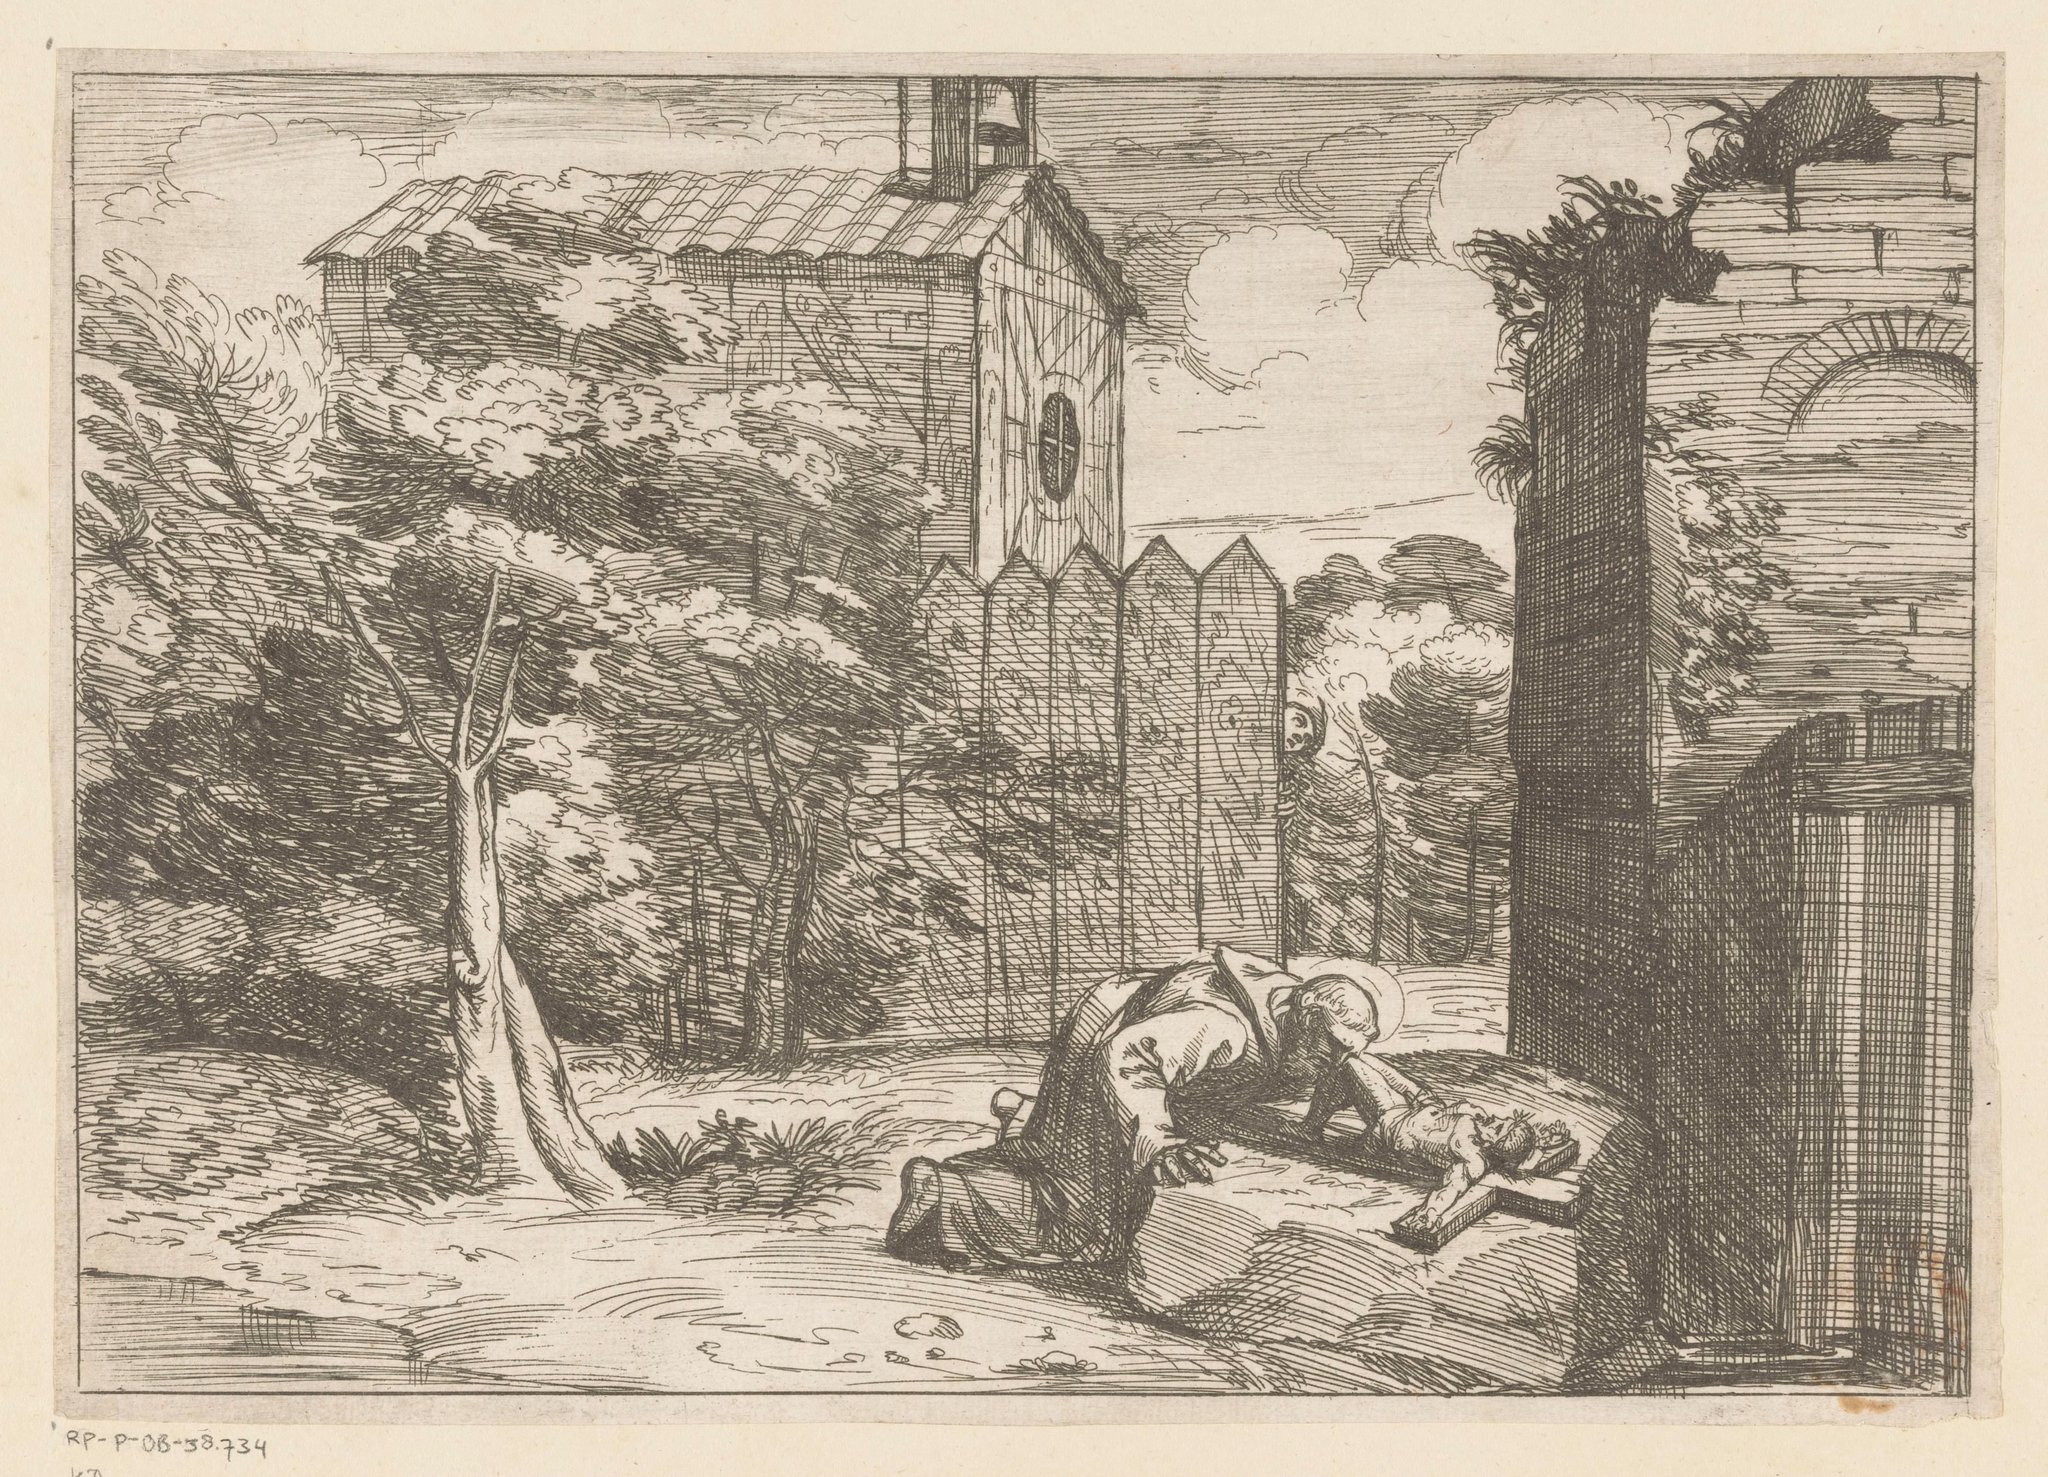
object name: print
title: Heilige knielend bij een crucifix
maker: Anonymous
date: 1600-1699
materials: paper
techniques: etching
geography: italy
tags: city-view, and landscape with man-made constructions, crucifix ~ personal devotion, meditation over skull and/or crucifix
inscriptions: collector's mark: Lugt 240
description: In een landschap bij een kerk knielt een heilige neer voor een crucifix. Vanachter een schutting kijkt een jongeling toe.